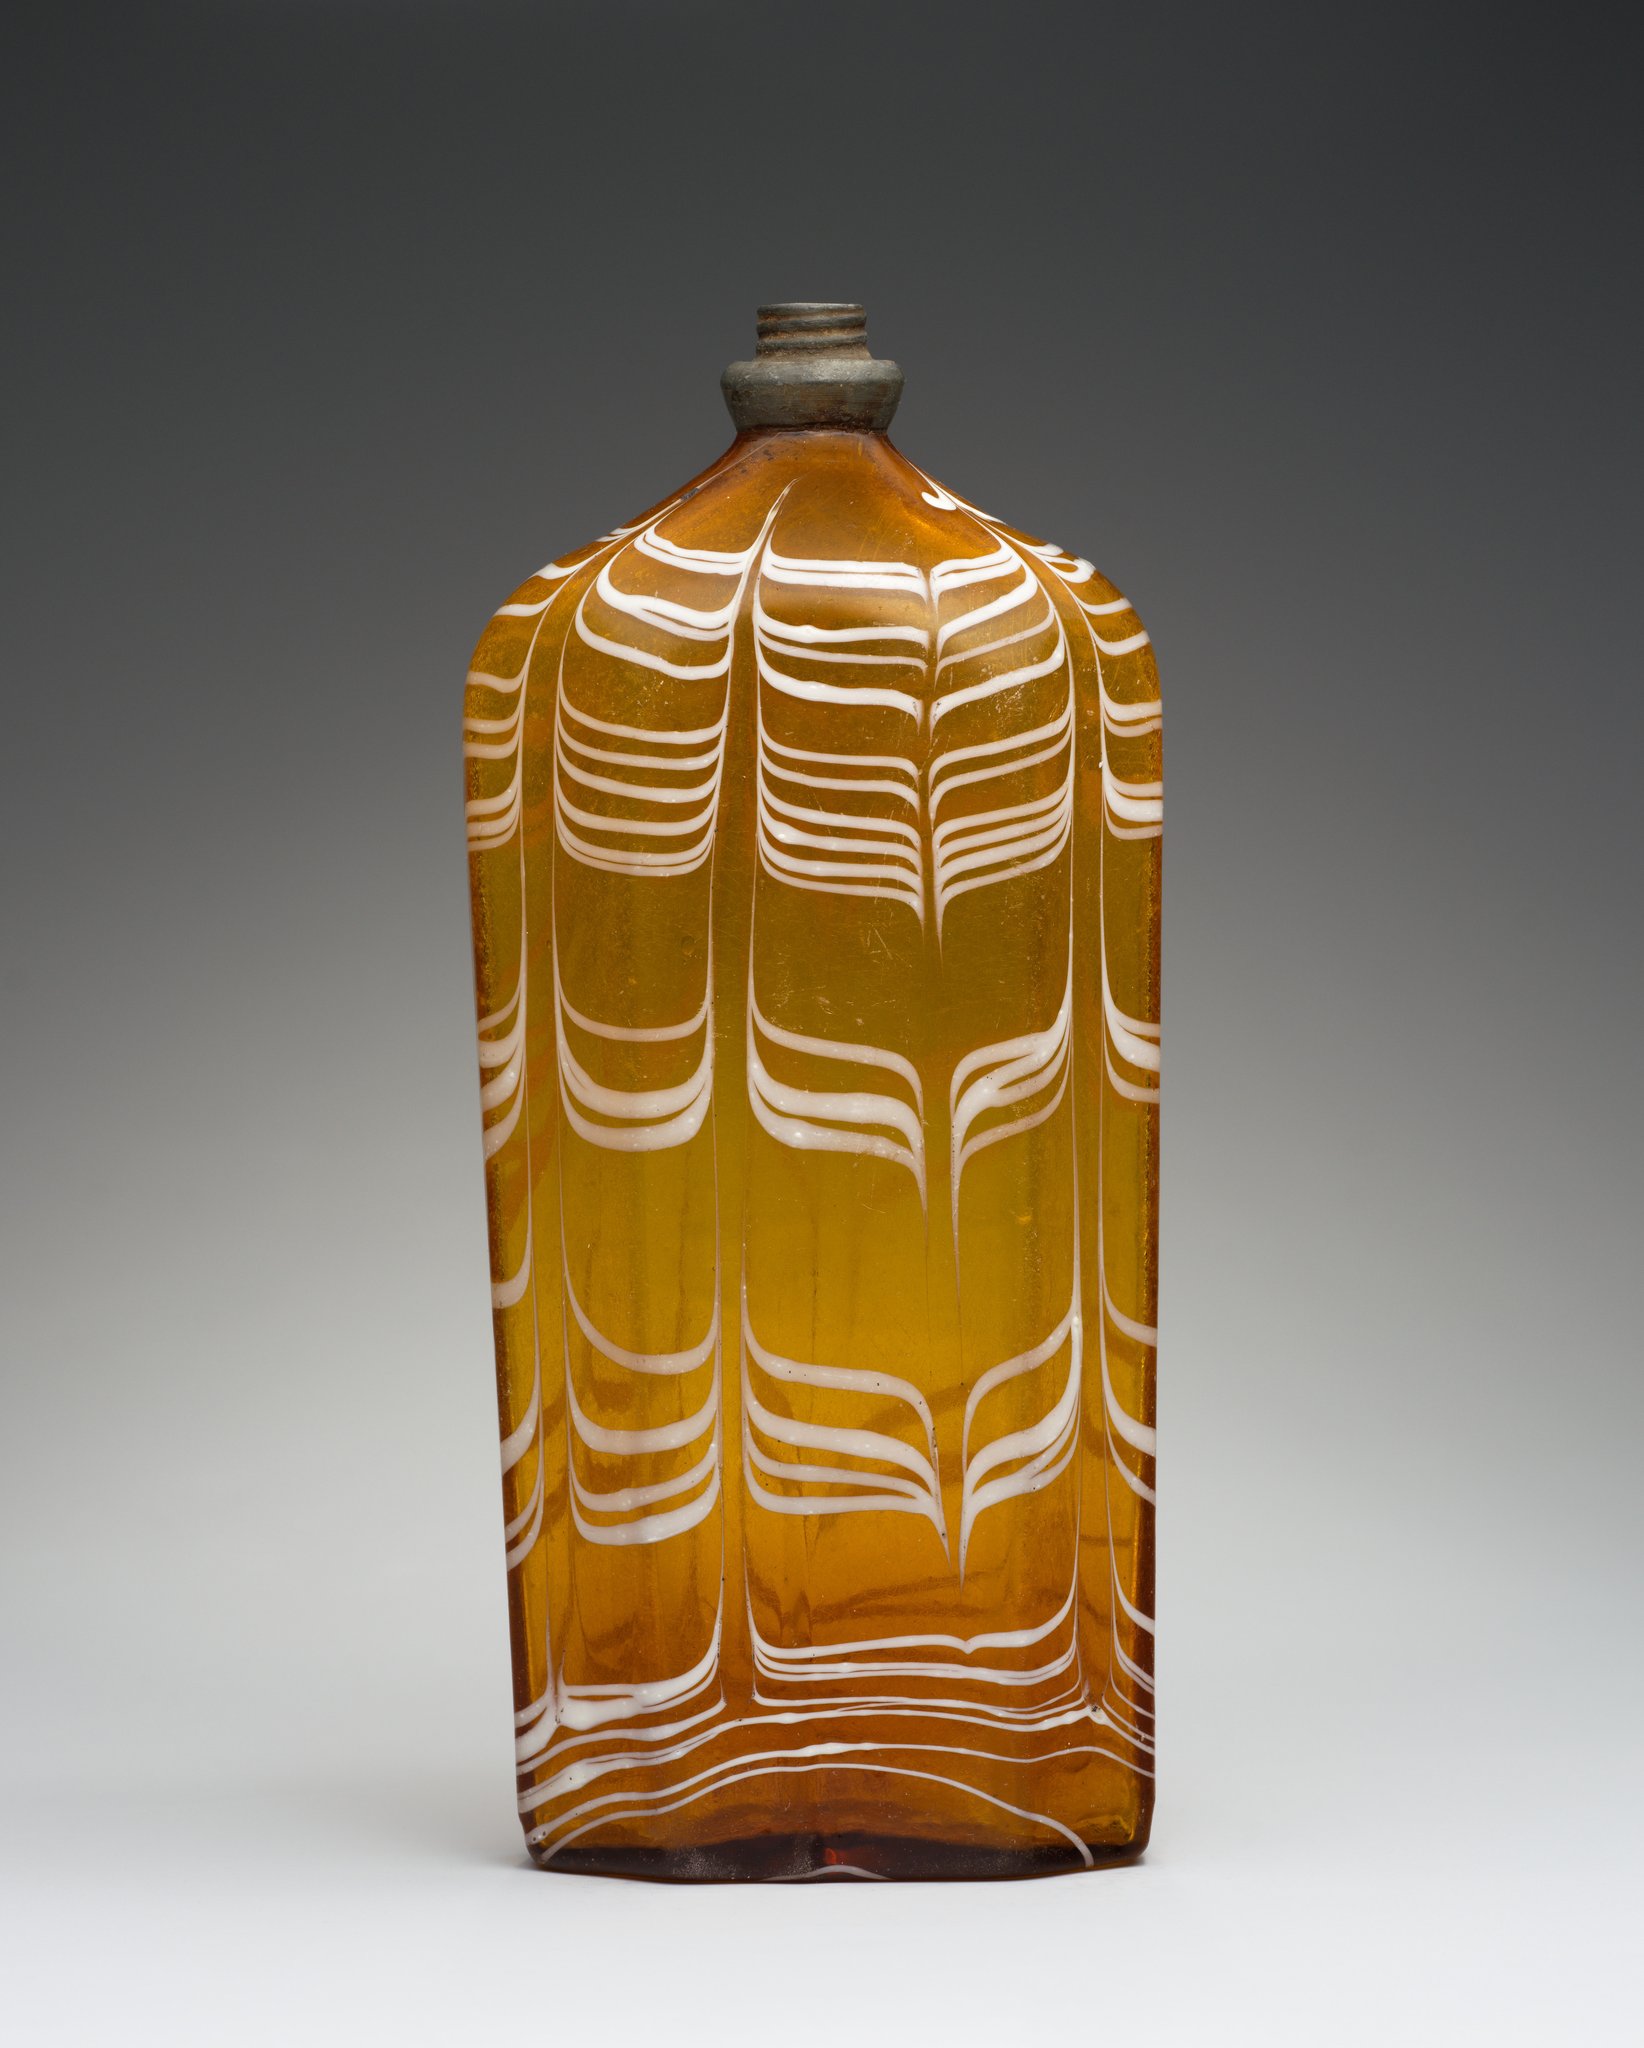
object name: bottle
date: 1701-1800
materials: glass, pewter